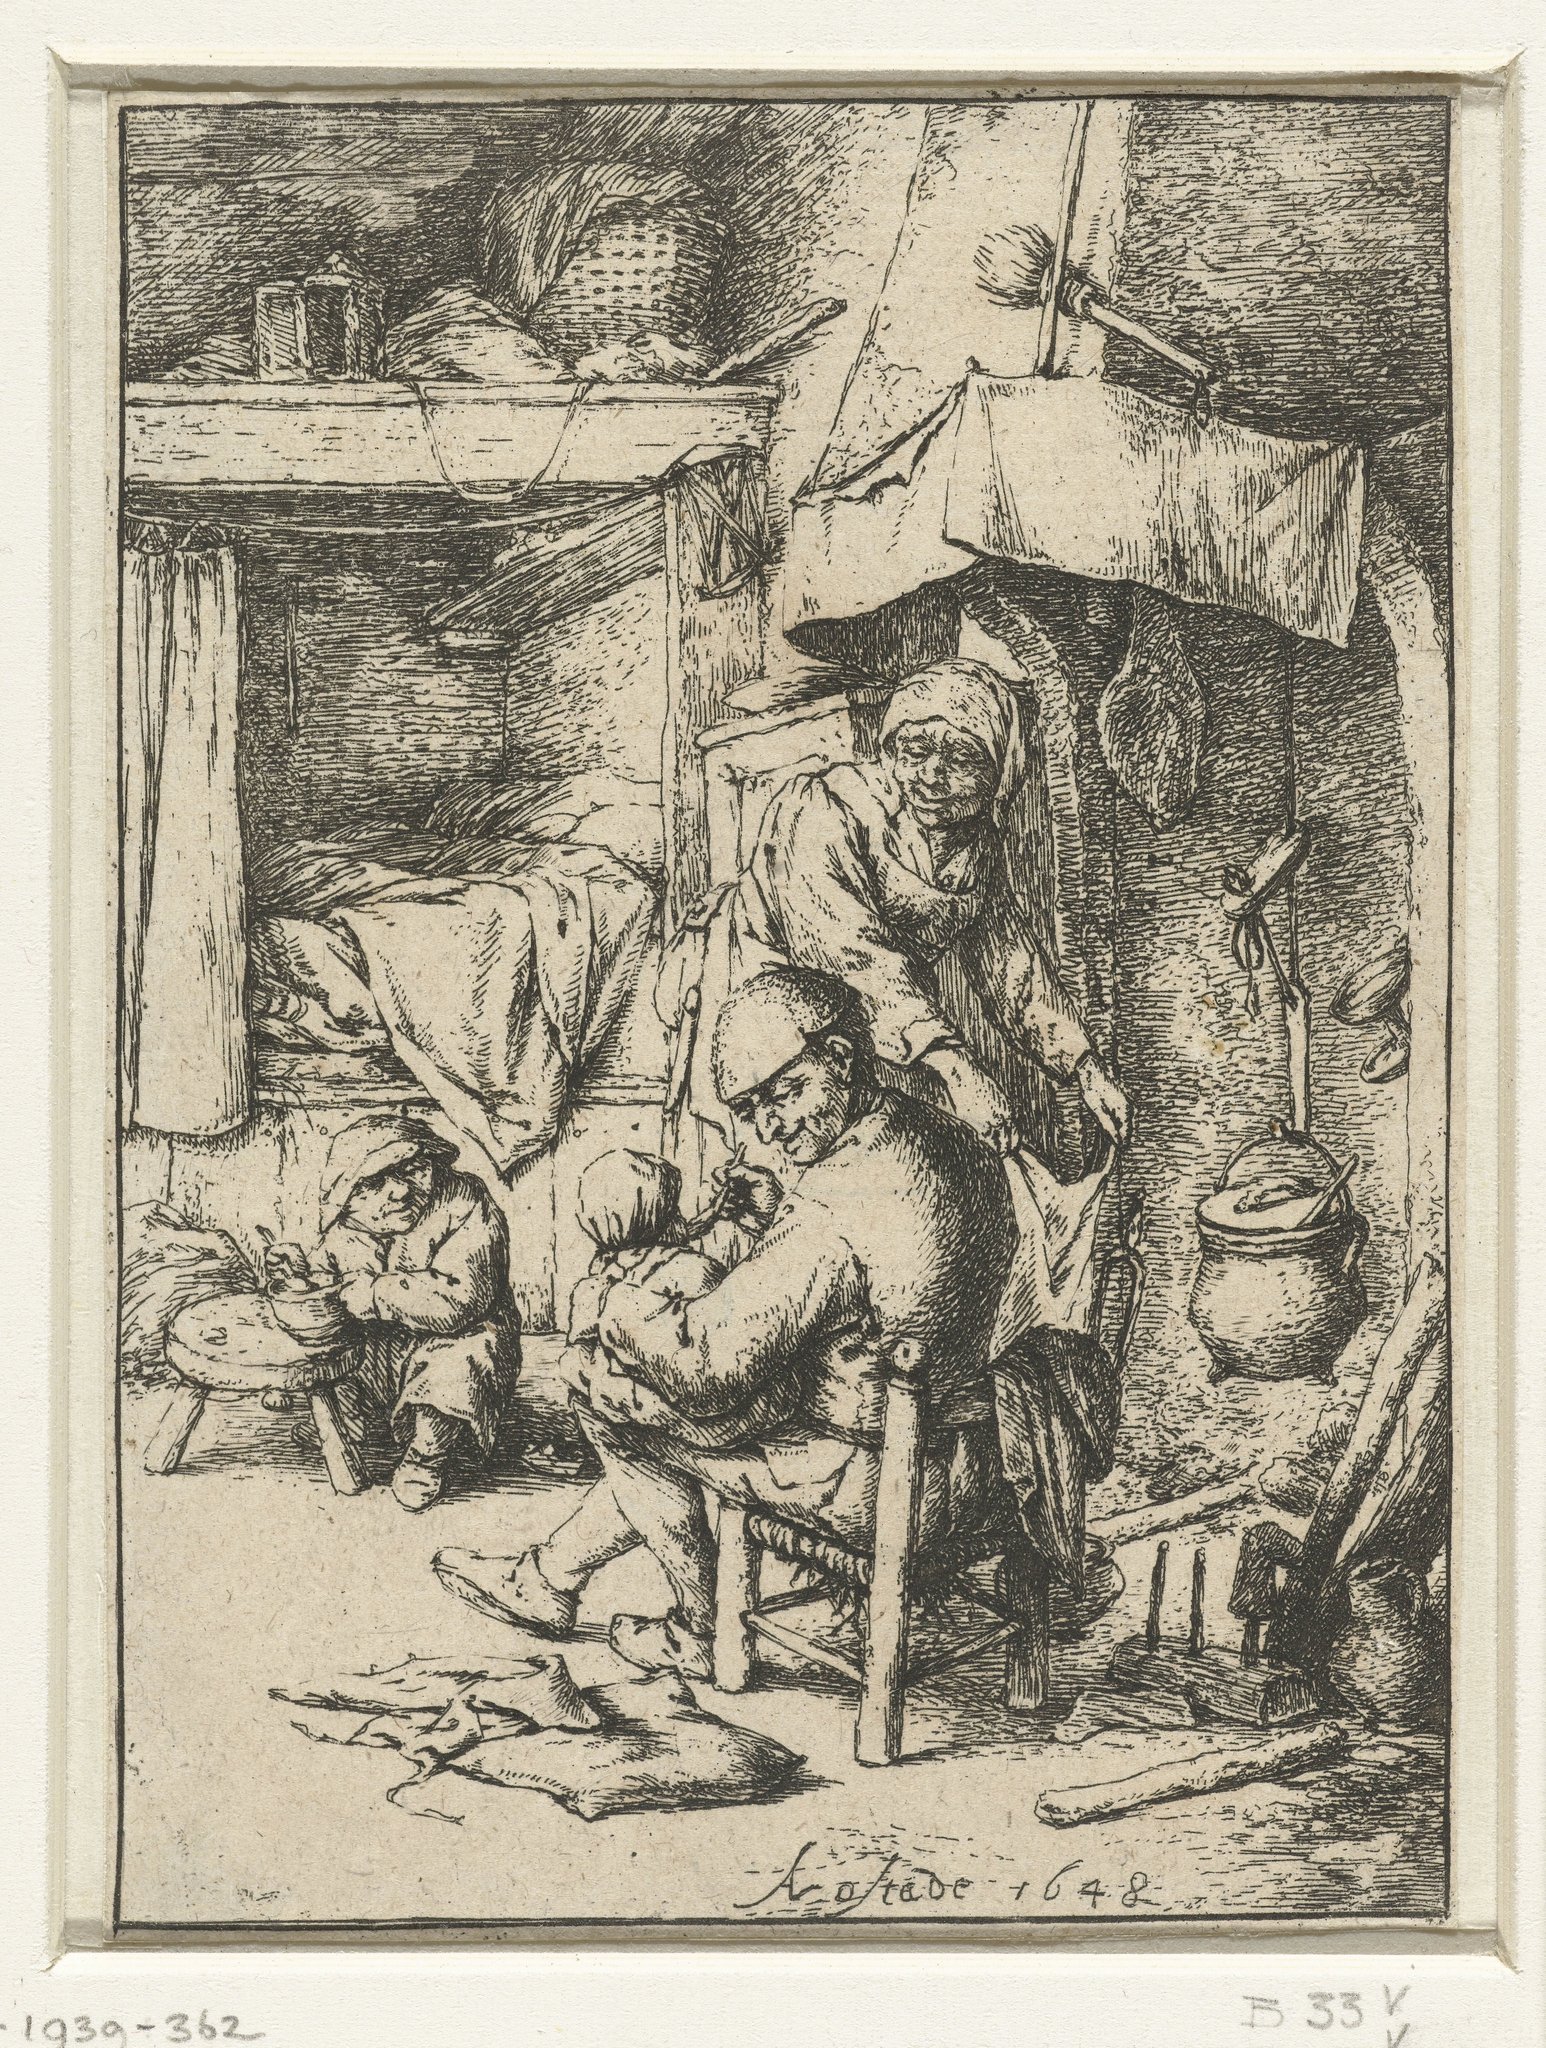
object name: print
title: Vader met kind op schoot in interieur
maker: adriaen van ostade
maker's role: draughtsman, painter, print maker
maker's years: 1610-1685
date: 1648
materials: paper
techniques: etching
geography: haarlem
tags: kitchen-interior, feeding a baby, father and child(ren), man and child(ren) (family group)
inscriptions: collector's mark: Lugt 2760, collector's mark: Lugt 2228a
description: Een vader geeft een klein kind op zijn schoot te eten, de moeder staat bij de haard waar een pot boven het vuur hangt. Een klein kind zit op de grond bij een kruk te eten. Dit boeren gezin is gesitueerd in een armoedig interieur met verschillende huishoudelijke attributen en op de achtergrond een bedstee.